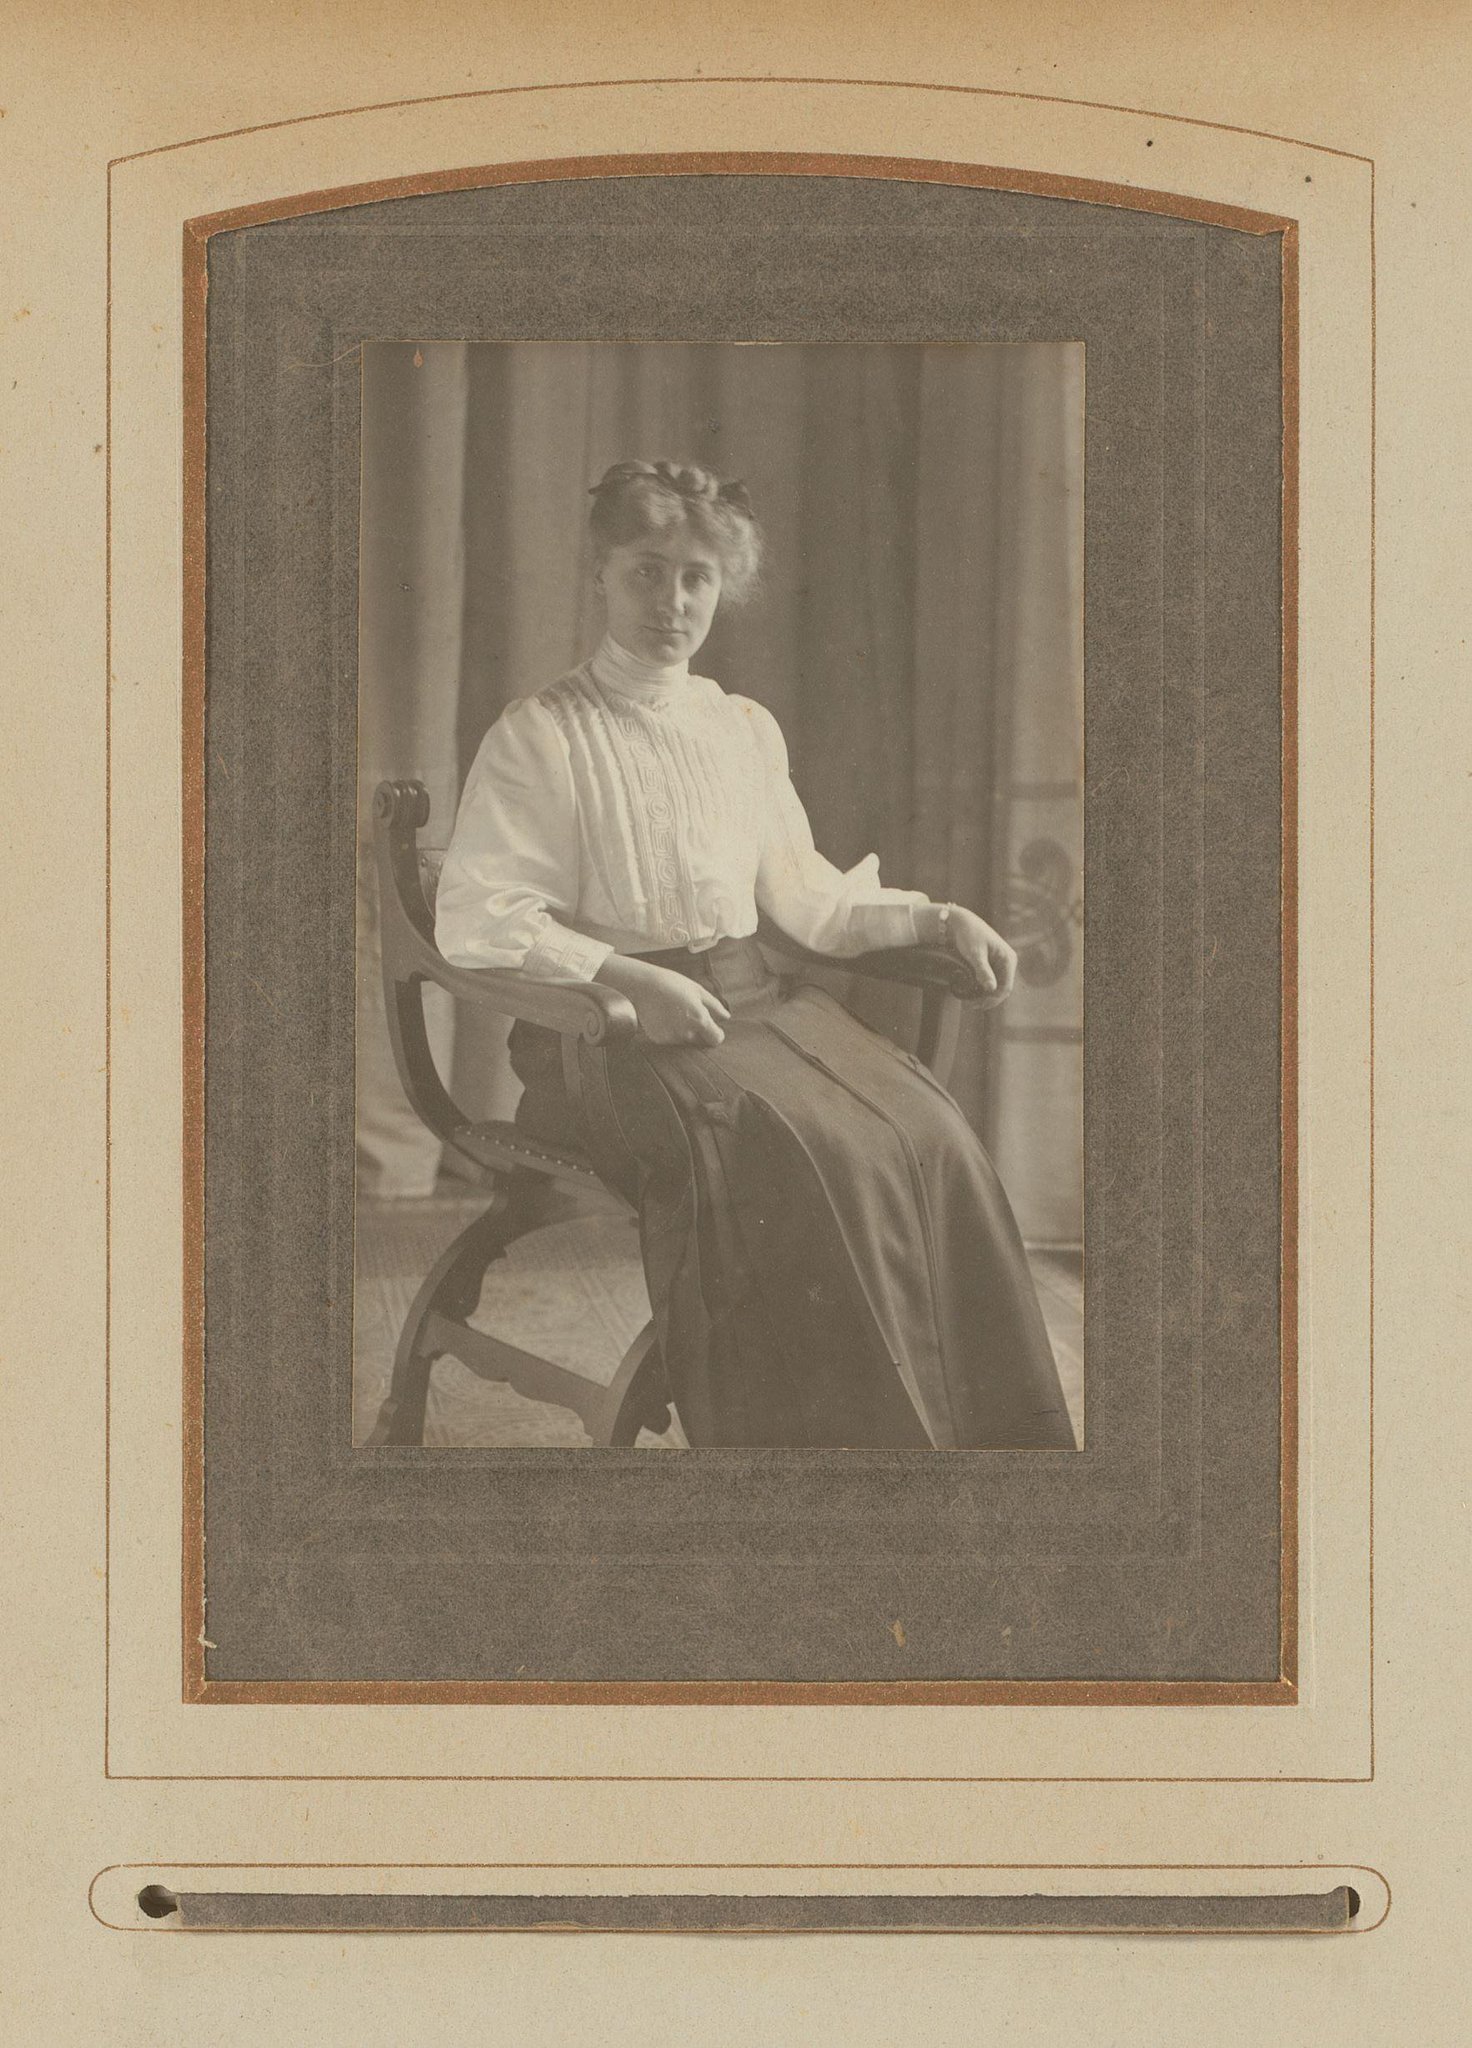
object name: cabinet photograph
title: Portret van een zittende vrouw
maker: Anonymous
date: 1895-1920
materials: cardboard, photographic support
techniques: matte daylight collodion silver print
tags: sitting figure - aa - female human figure, historical persons - bb - woman